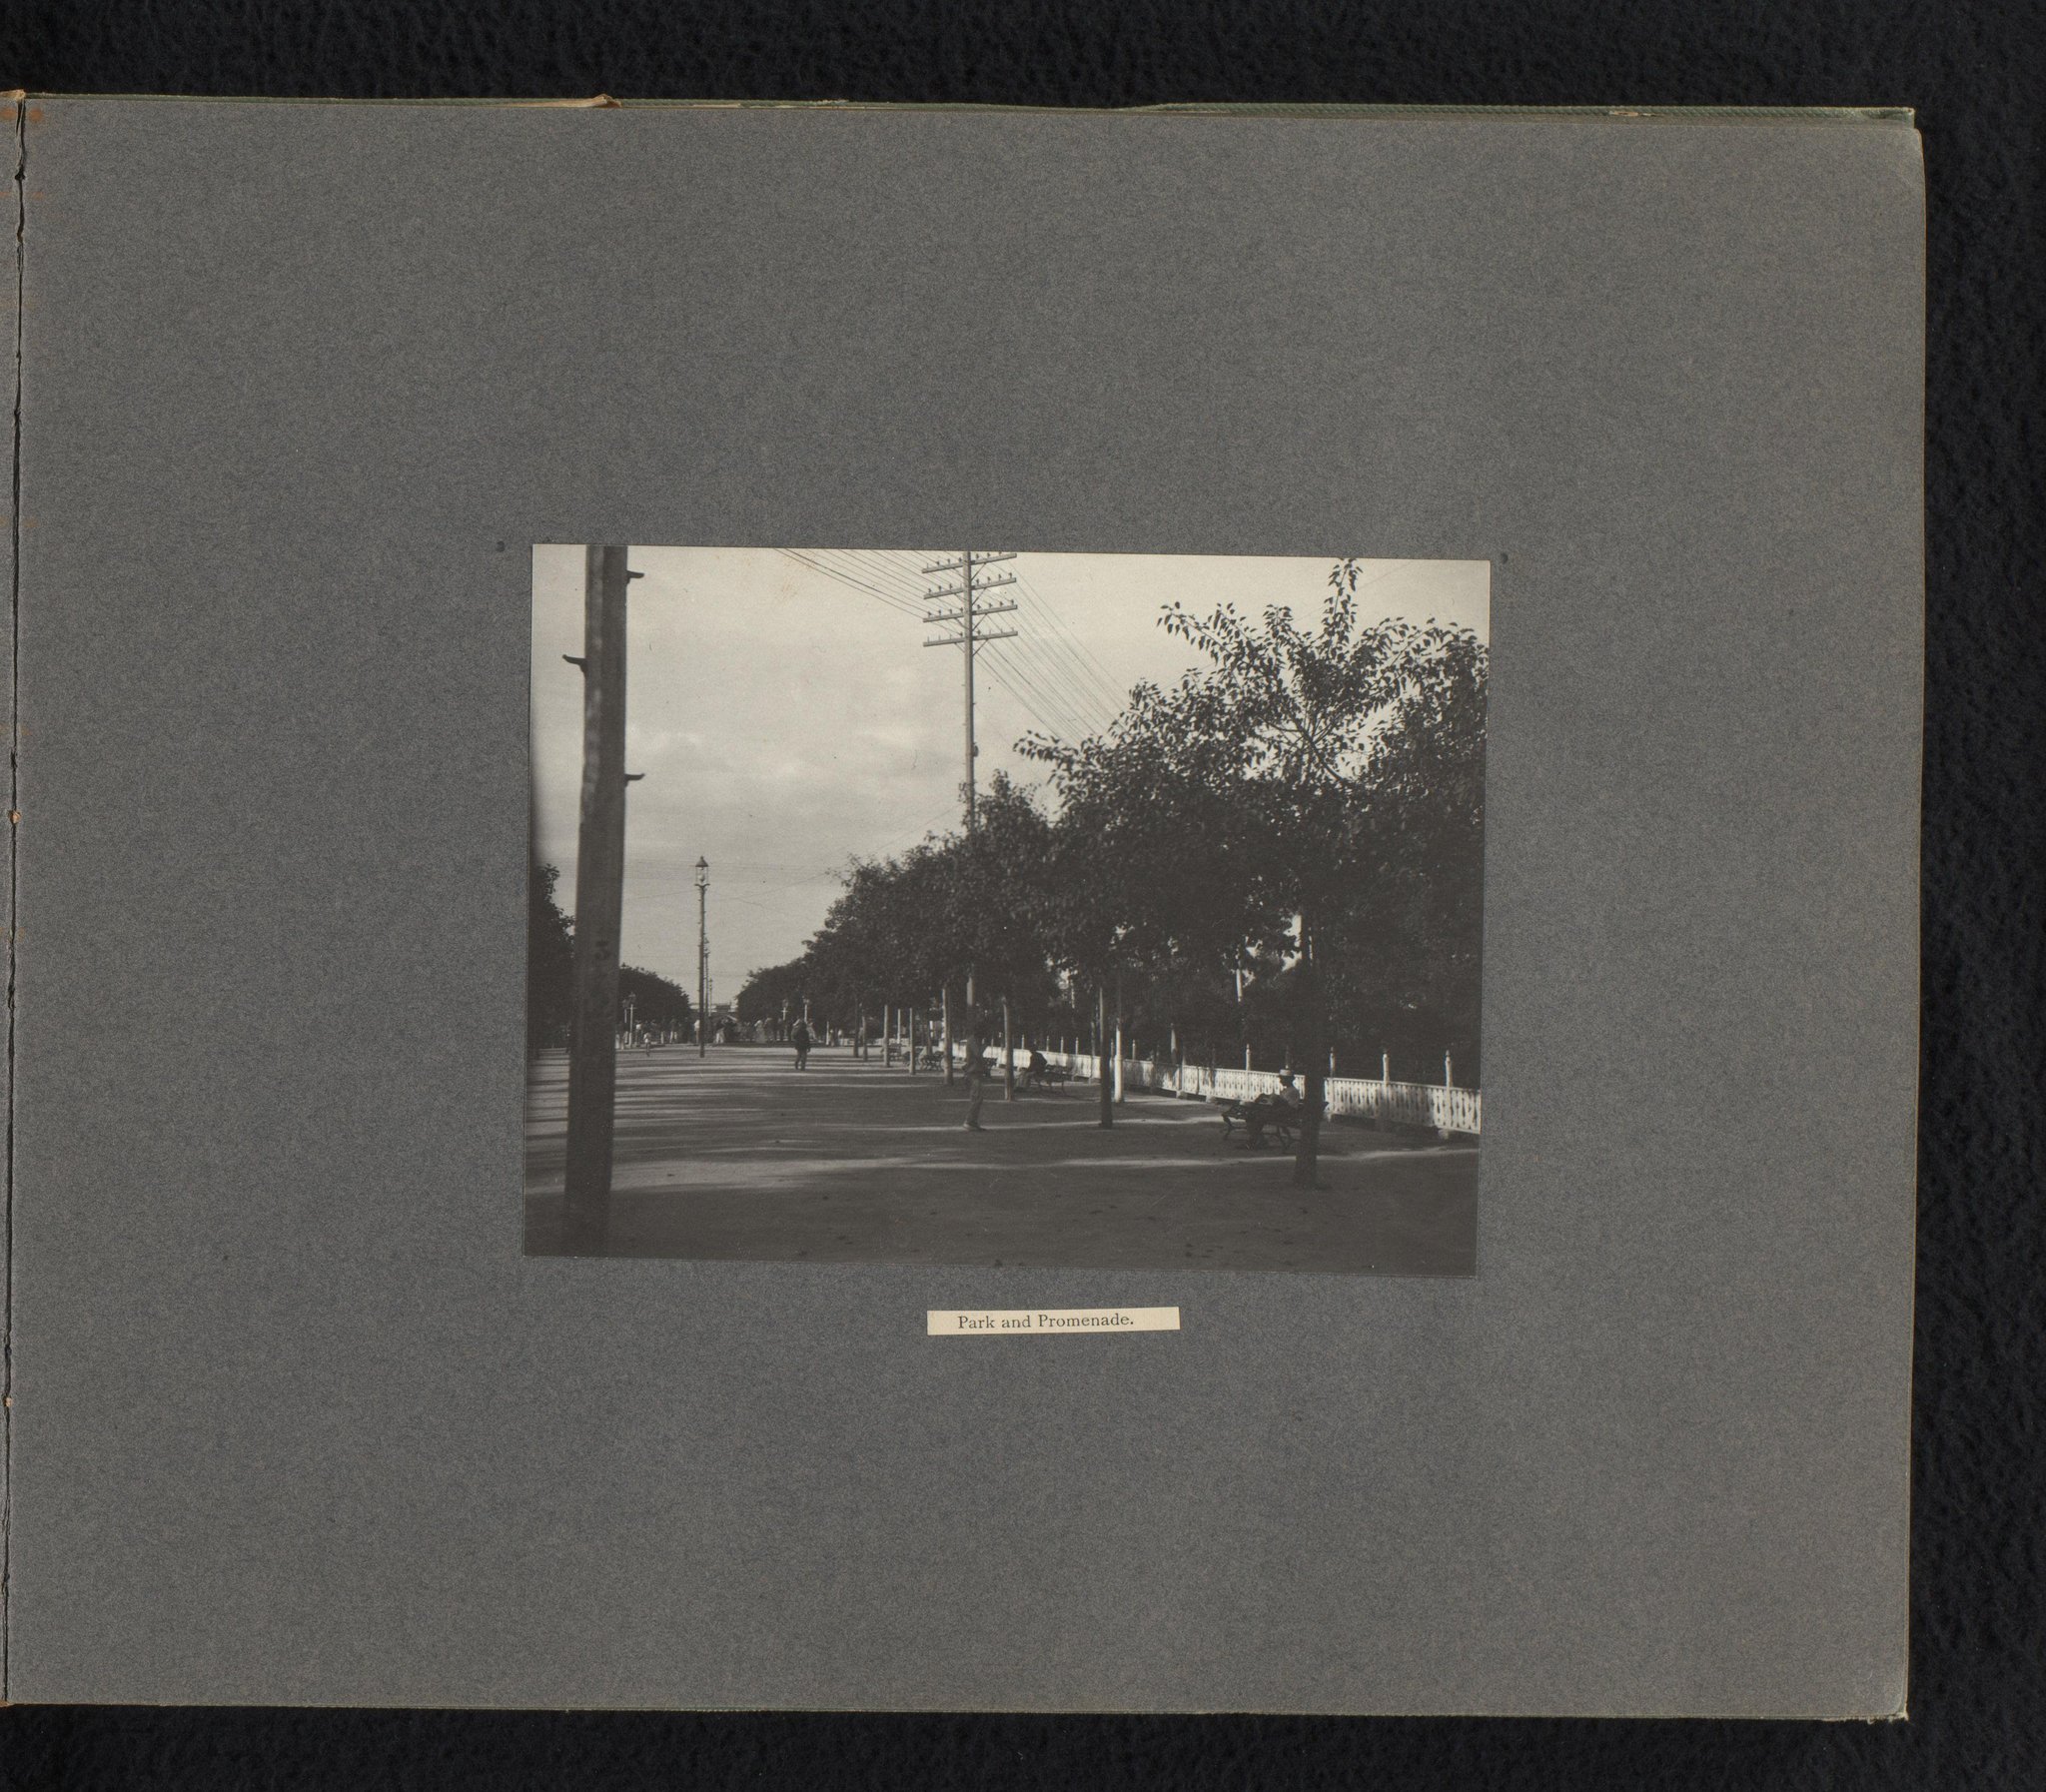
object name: photograph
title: Gezicht op een promenade in Havana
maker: Anonymous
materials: paper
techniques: platinum process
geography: havana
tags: avenue, boulevard, promenade, esplanade (+ city(-scape) with figures, staffage)